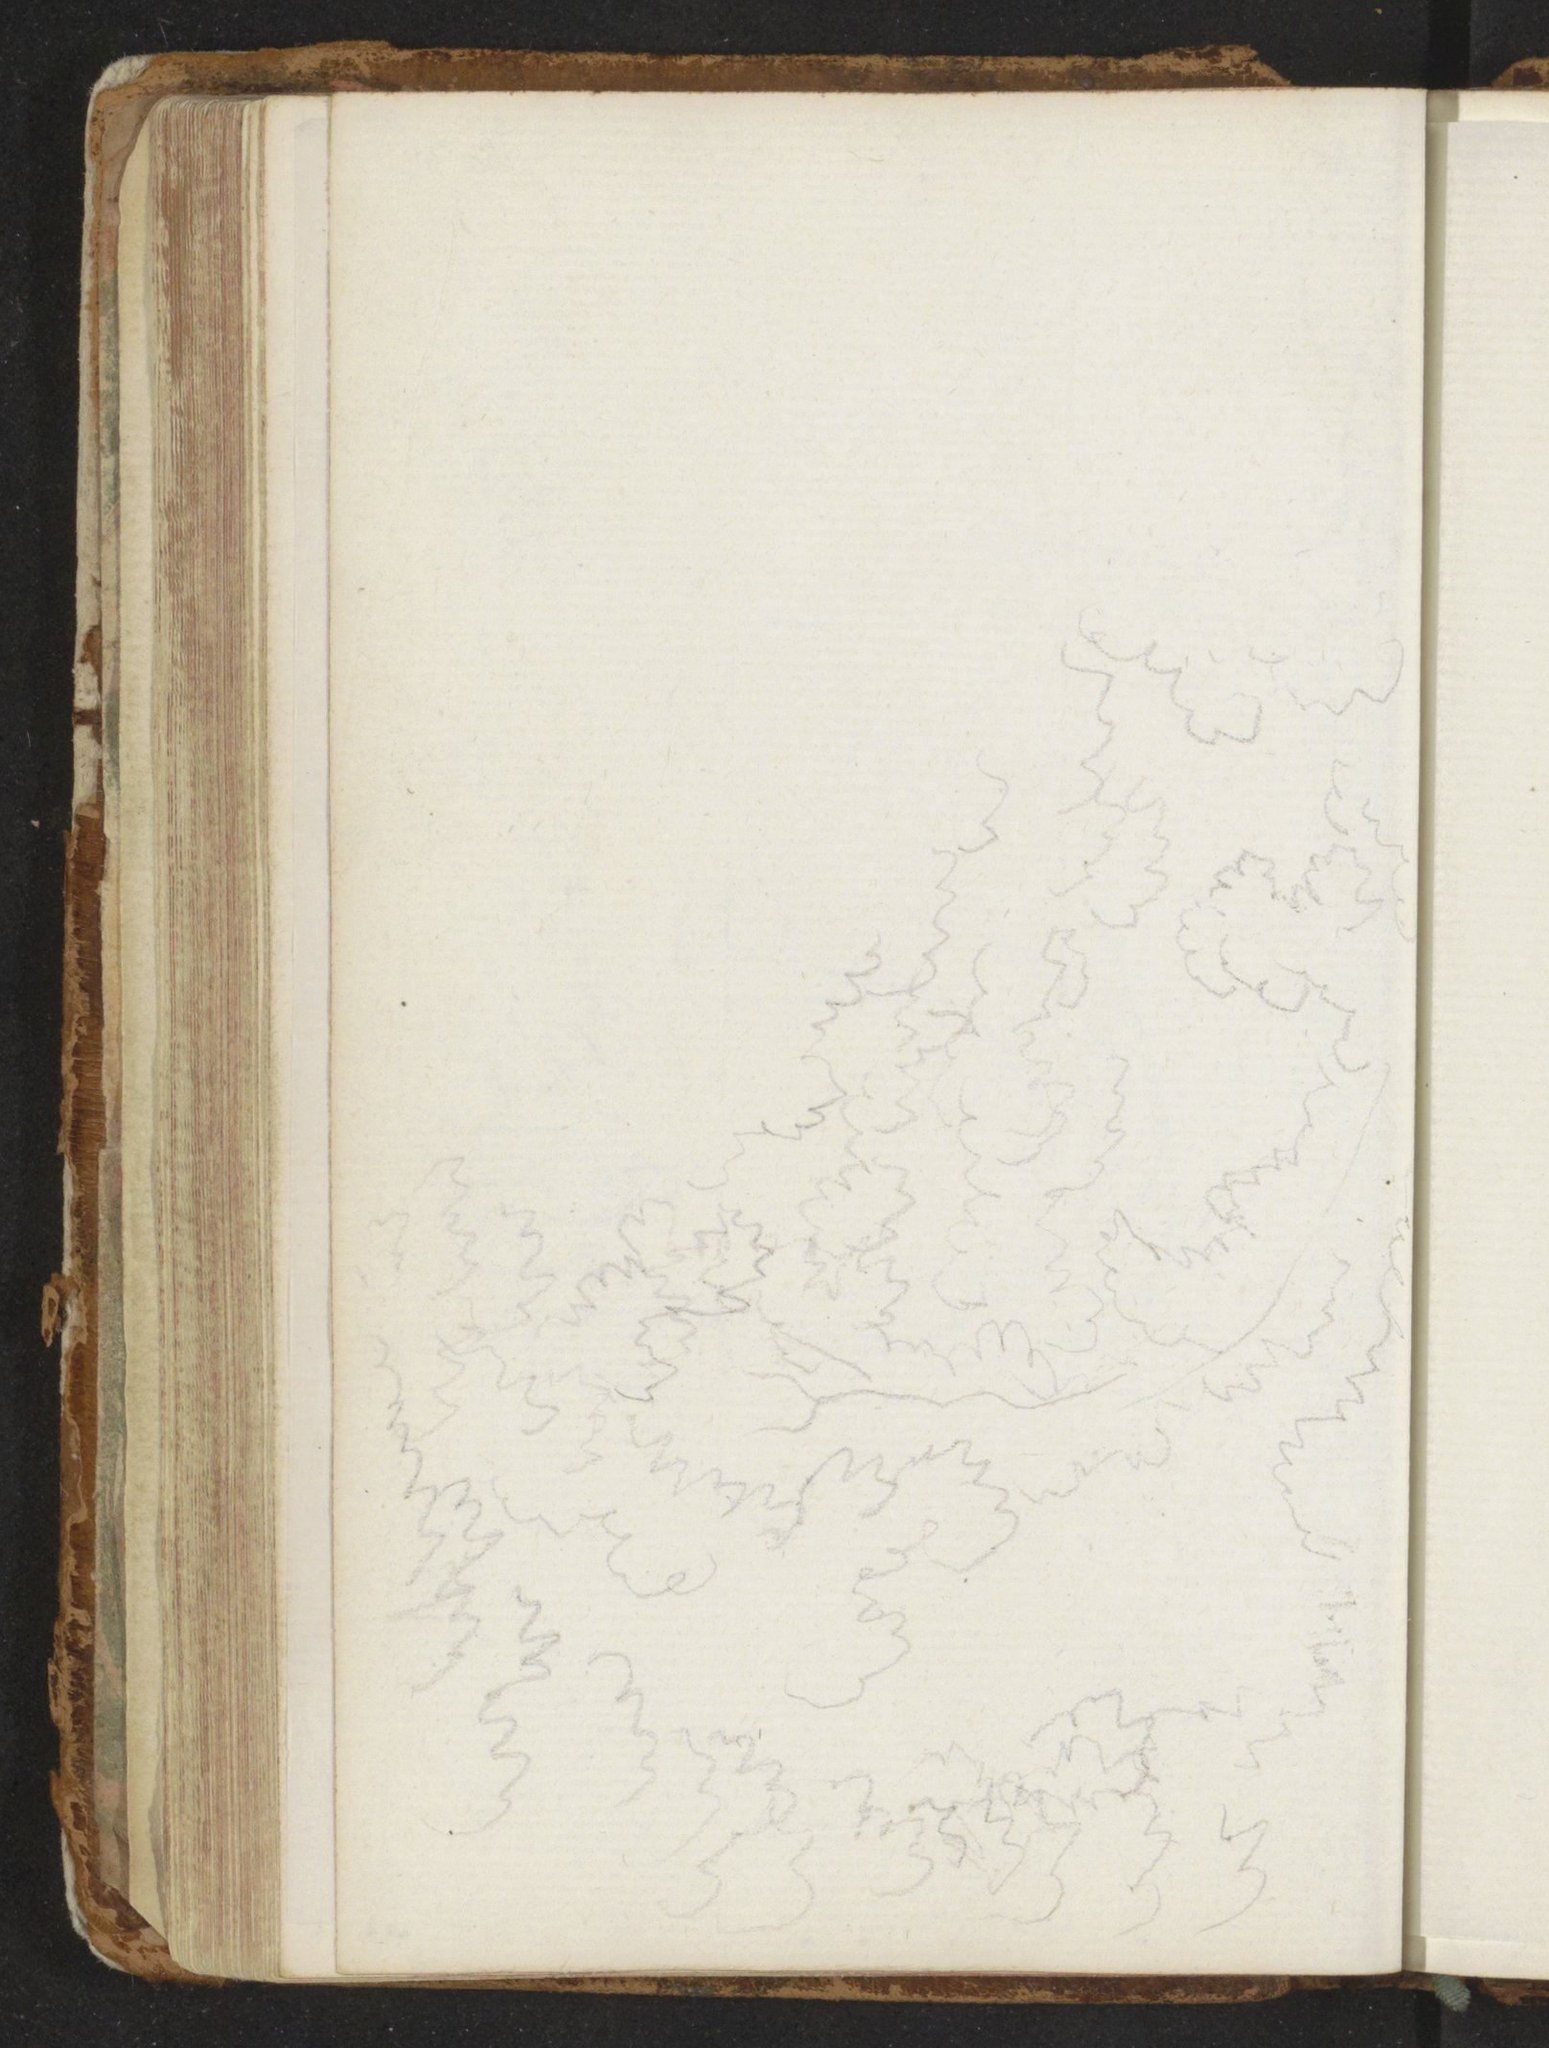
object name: sketchbook leaf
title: Bladerdek van een boom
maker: jean honoré fragonard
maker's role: draughtsman, painter, print maker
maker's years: 1732-1806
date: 1765-1775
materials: paper, pencil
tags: trees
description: Blad 34 verso uit een schetsboek met 83 bladen.